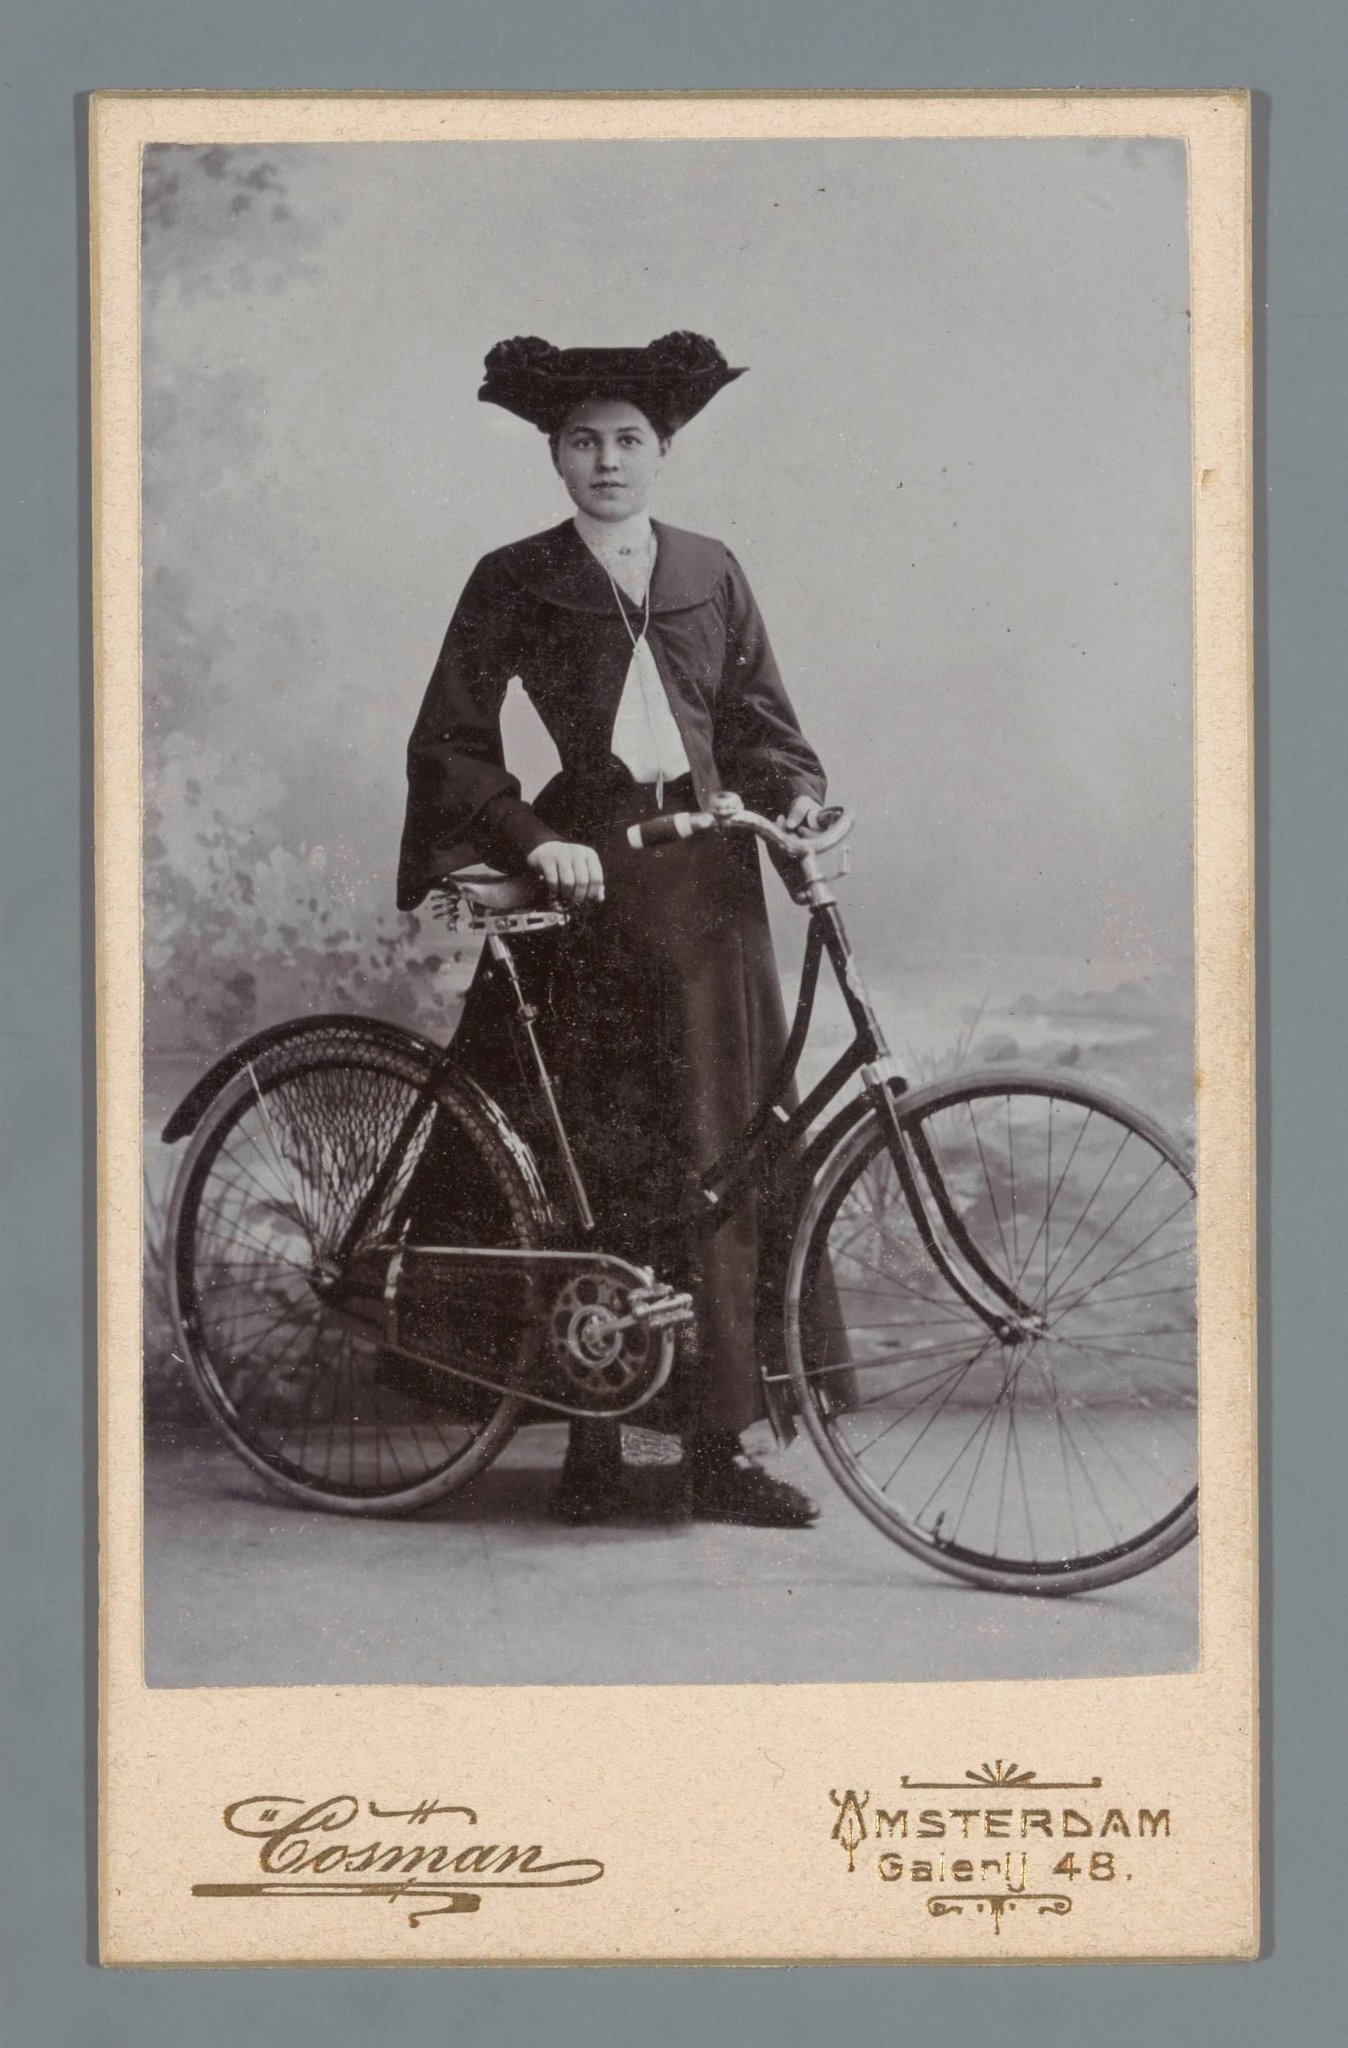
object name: photograph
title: Portret van een onbekende vrouw met een fiets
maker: max cosman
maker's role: fotograaf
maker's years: 1852-1894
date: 1890-1905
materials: cardboard, photographic support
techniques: gelatin silver print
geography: amsterdam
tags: adult woman, bicycle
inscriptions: inscription: ‘Cosman Amsterdam Galerij 48’